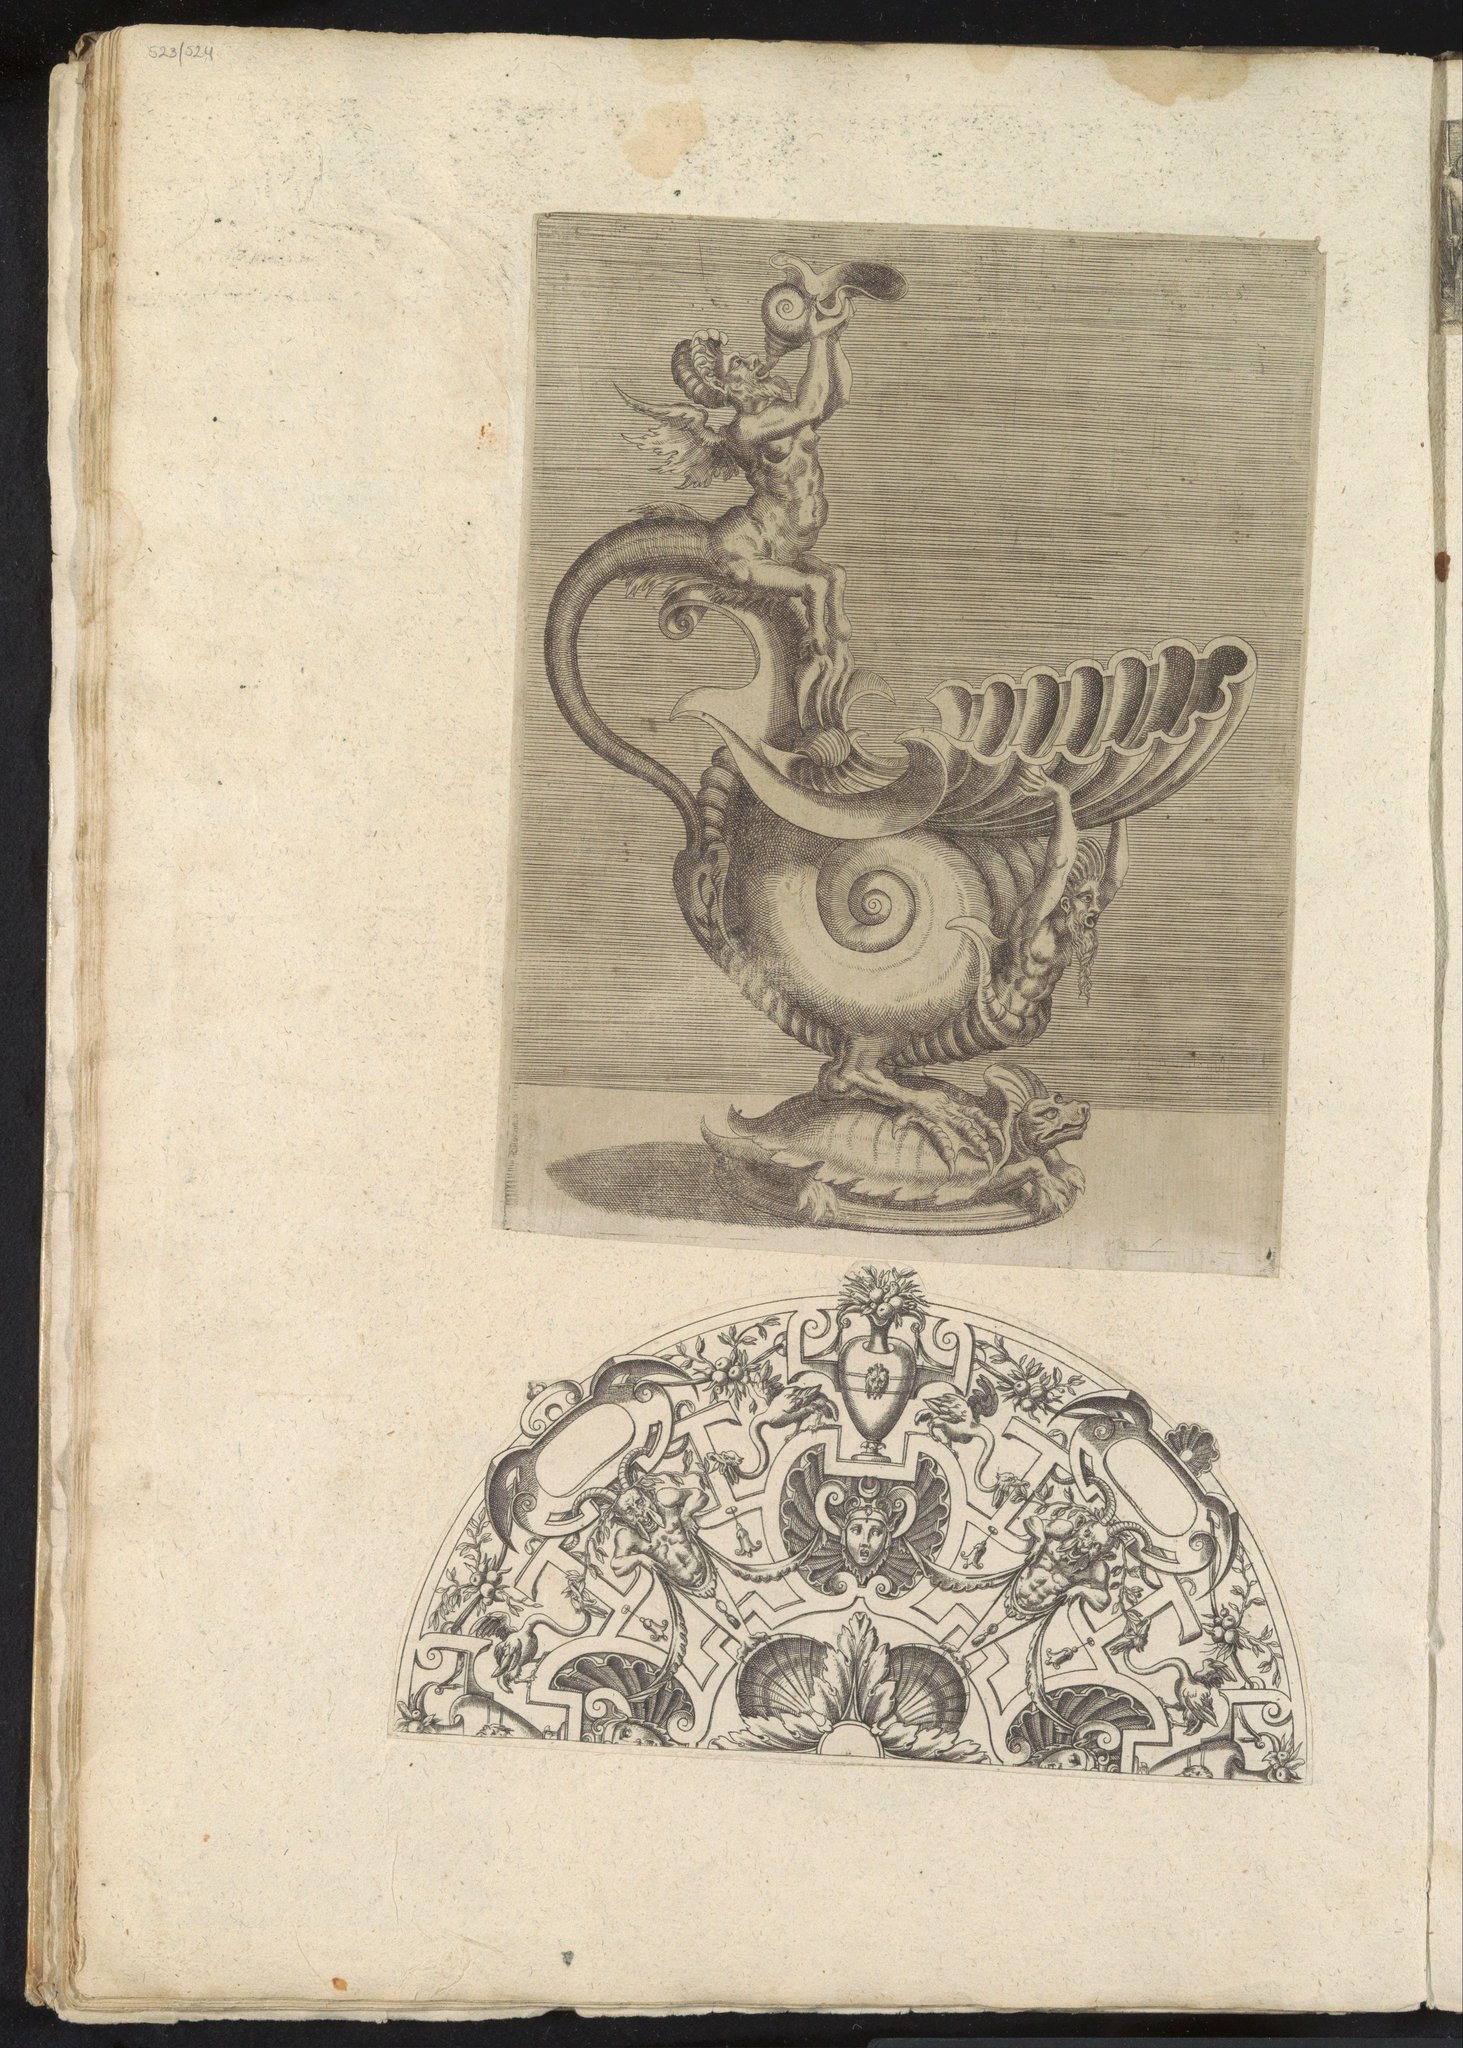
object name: album leaf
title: Albumblad met twee prenten met een kan en een ornamentele halve cirkel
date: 1500-1599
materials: paper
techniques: engraving, etching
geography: low countries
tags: kitchen-utensils: cauldron, ornaments ~ art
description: Albumblad met twee uitgeknipte prenten: een ornamentele kan en een ornamentele halve cirkel.